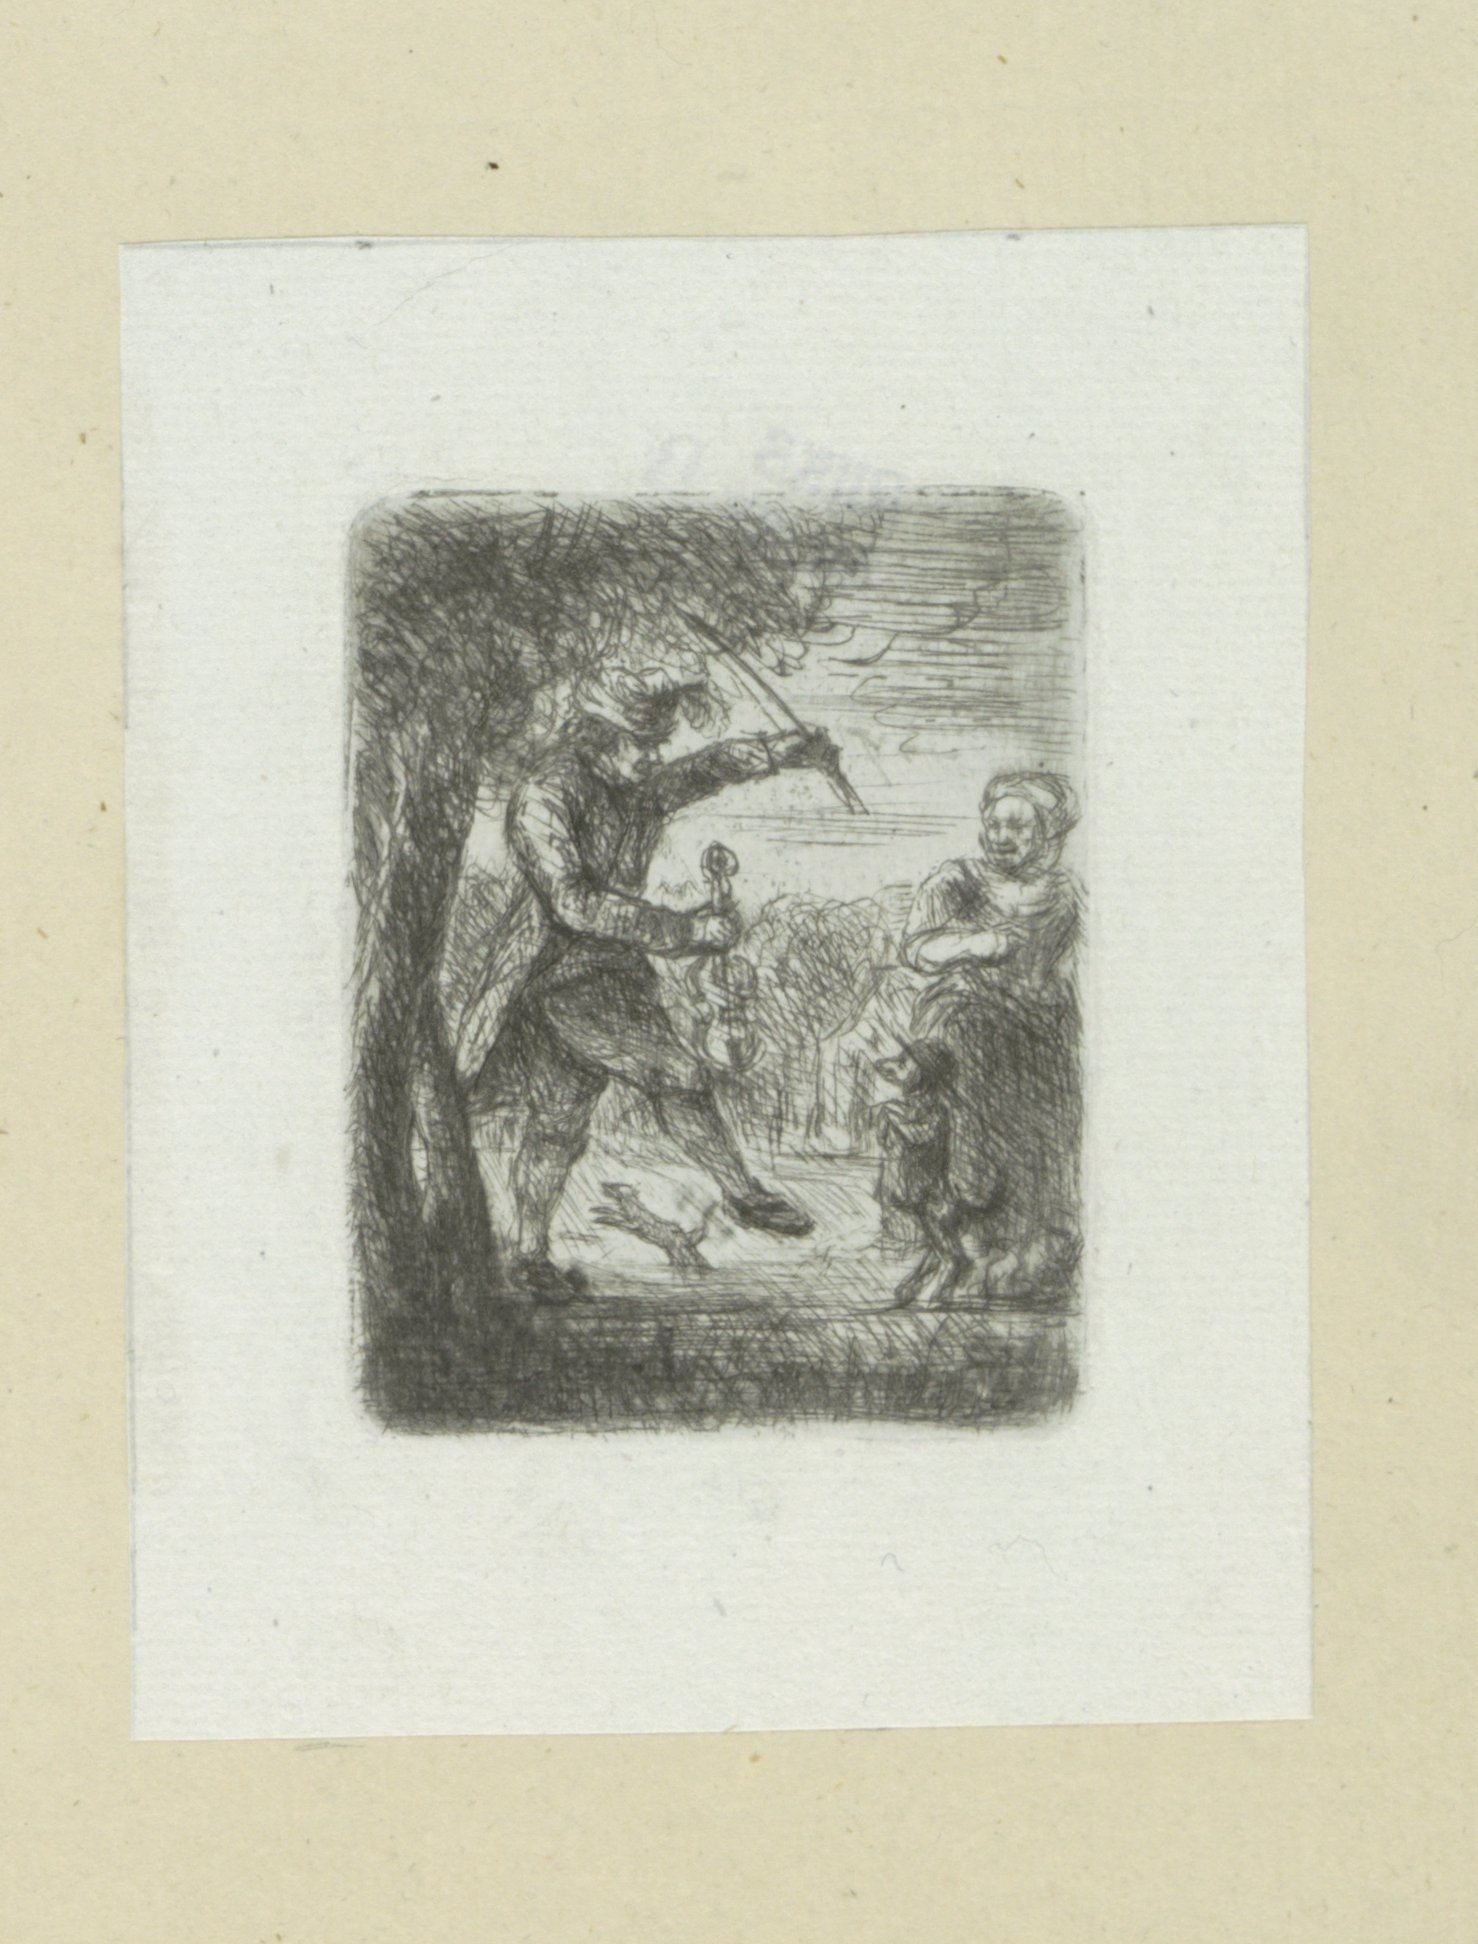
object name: print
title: The Compleat Work of Etchings by John Chalon / Oeuvre Complette des Eaux Fortes par Jean Chalon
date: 1802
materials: paper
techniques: drypoint, etching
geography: london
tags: one person playing string instrument (bowed), violin, fiddle, dogs (circus performance), instrumental popular music, earning money with other animals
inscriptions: collector's mark: ‘RIJKS / MUSM’, collector's mark: ‘B’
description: Een straatmuzikant speelt viool voor een dienstmeid. Twee honden dansen om hem heen. De prent maakt deel uit van een album.